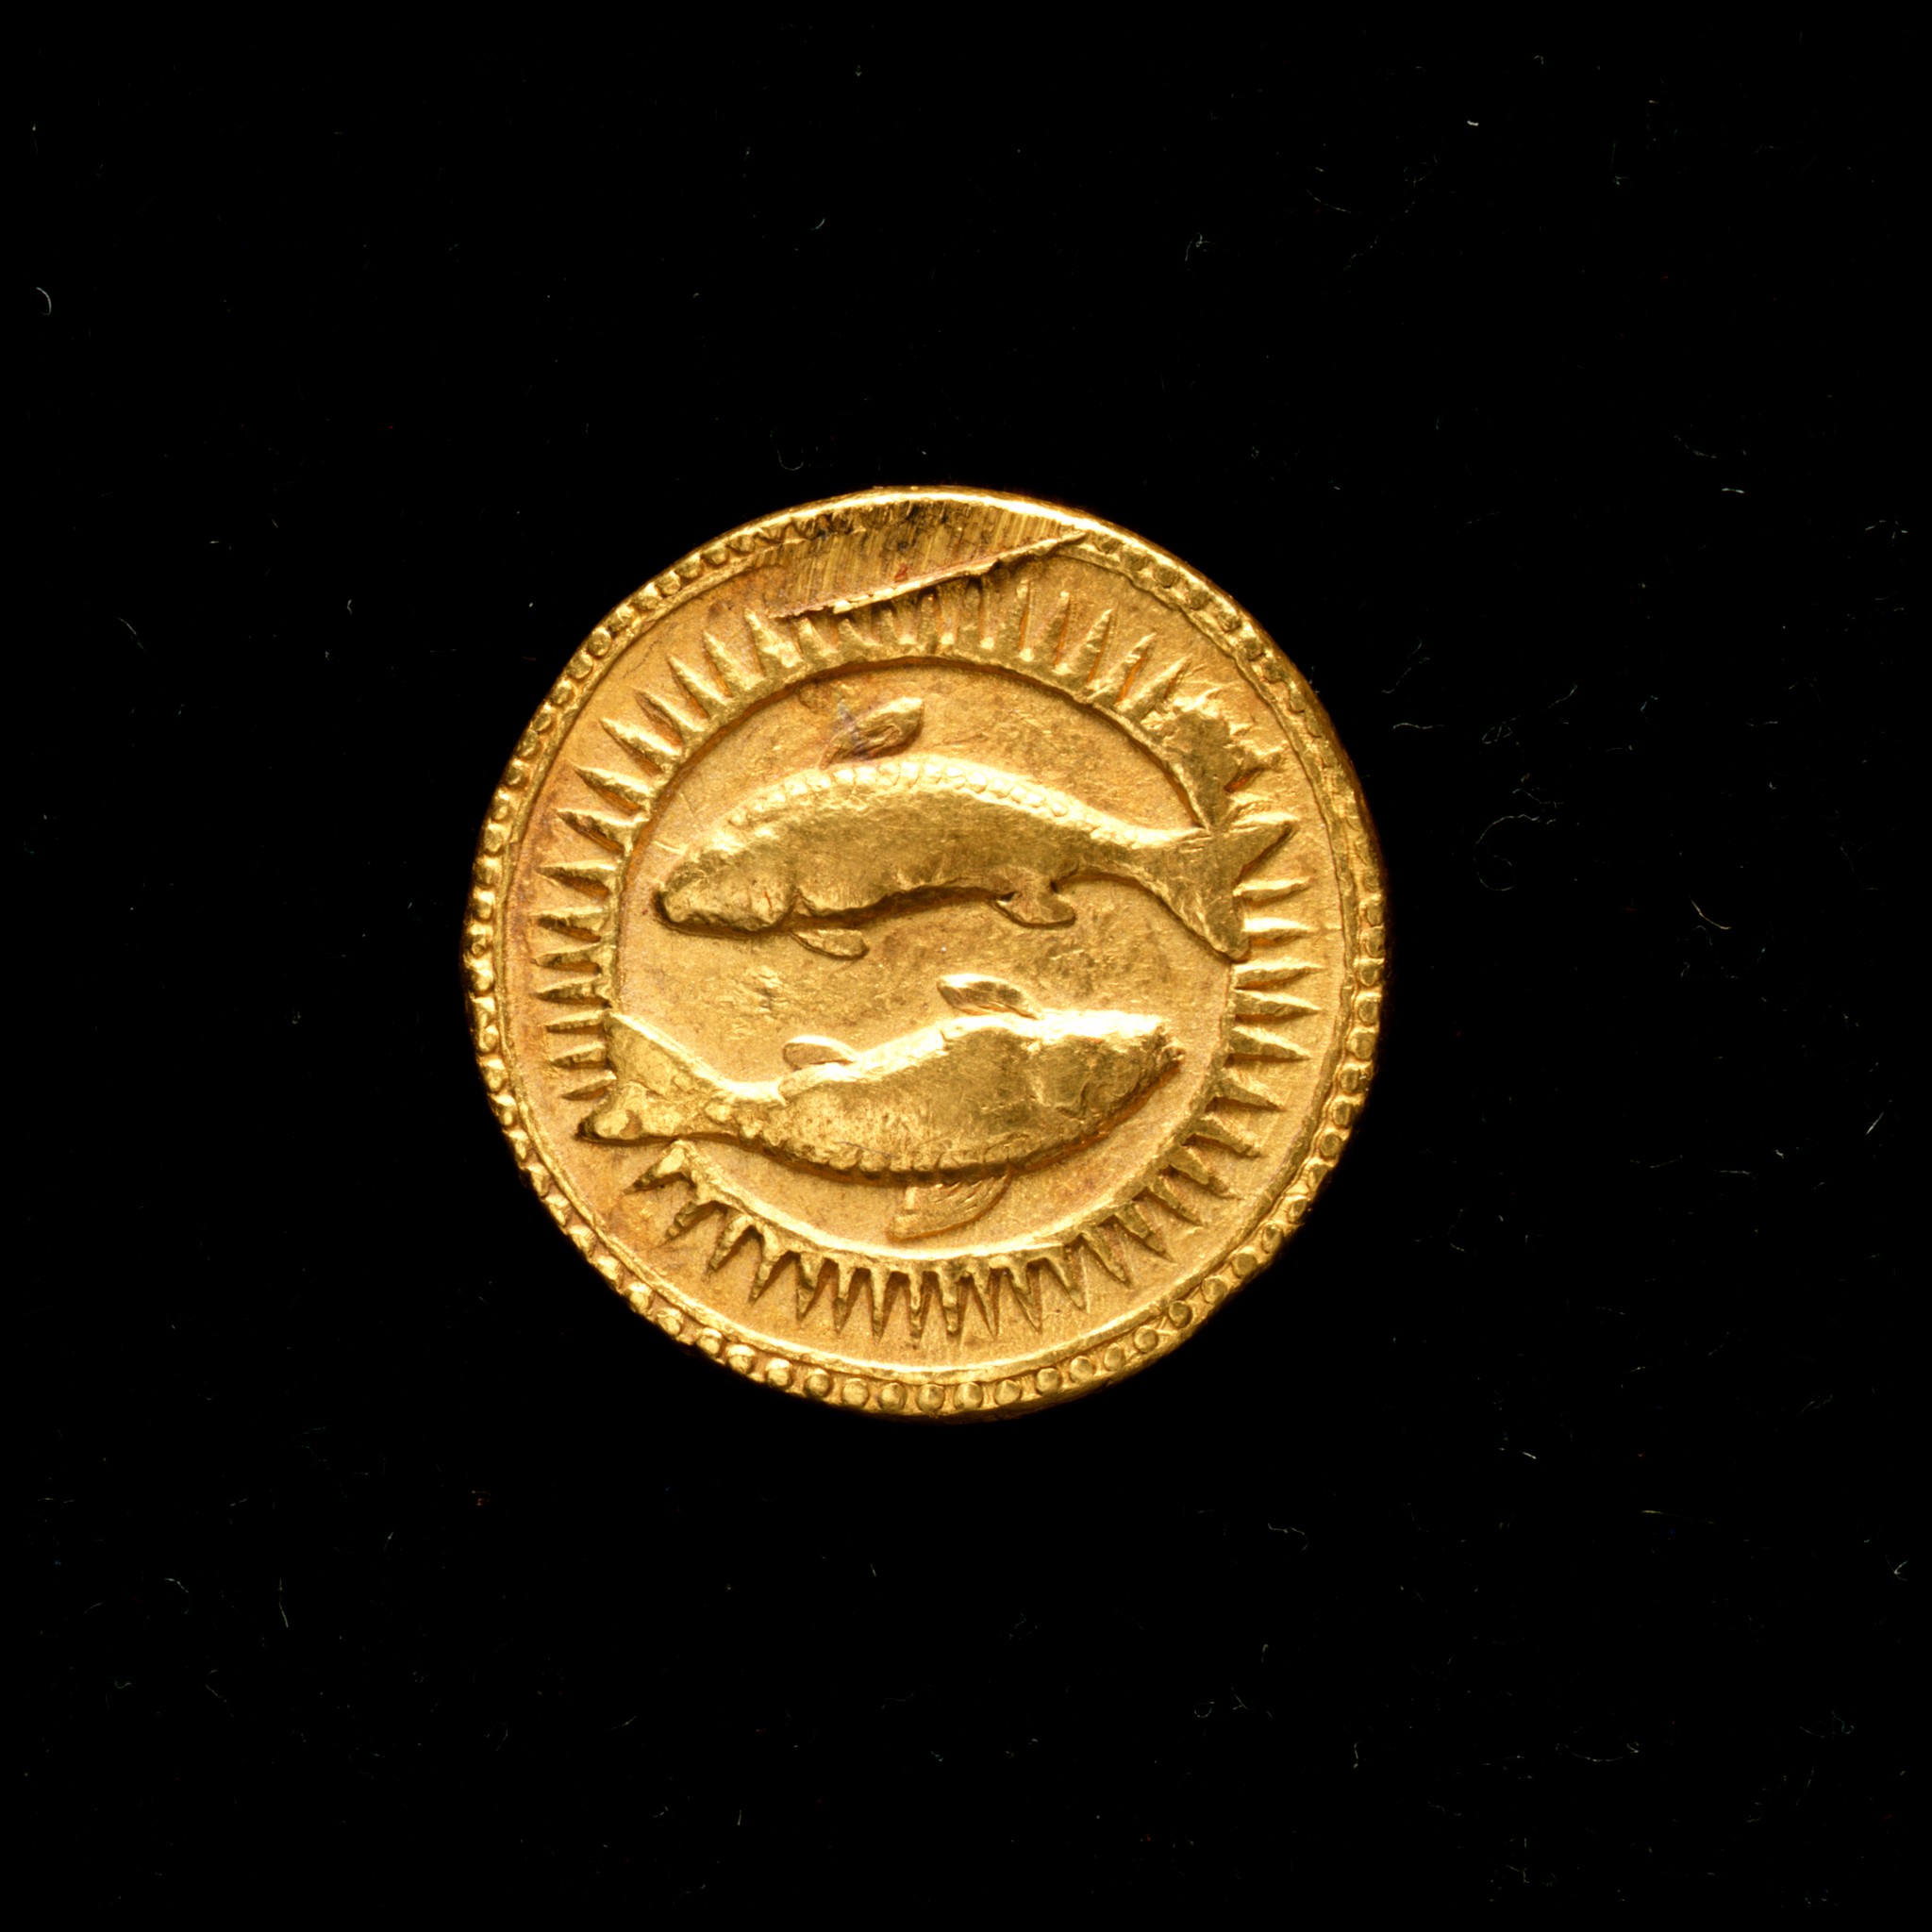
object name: coin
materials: gold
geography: india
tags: fish